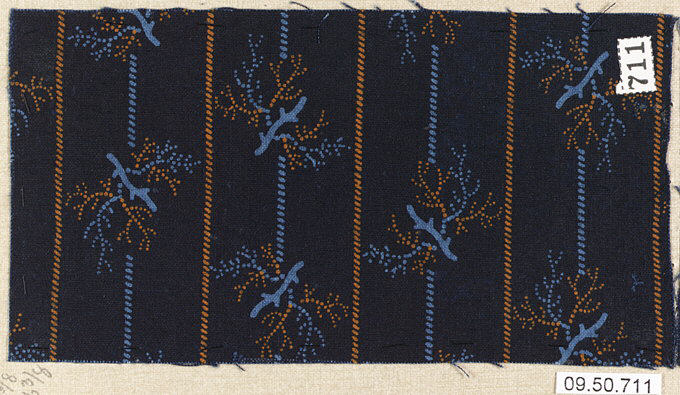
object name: piece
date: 1801-1900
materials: cotton